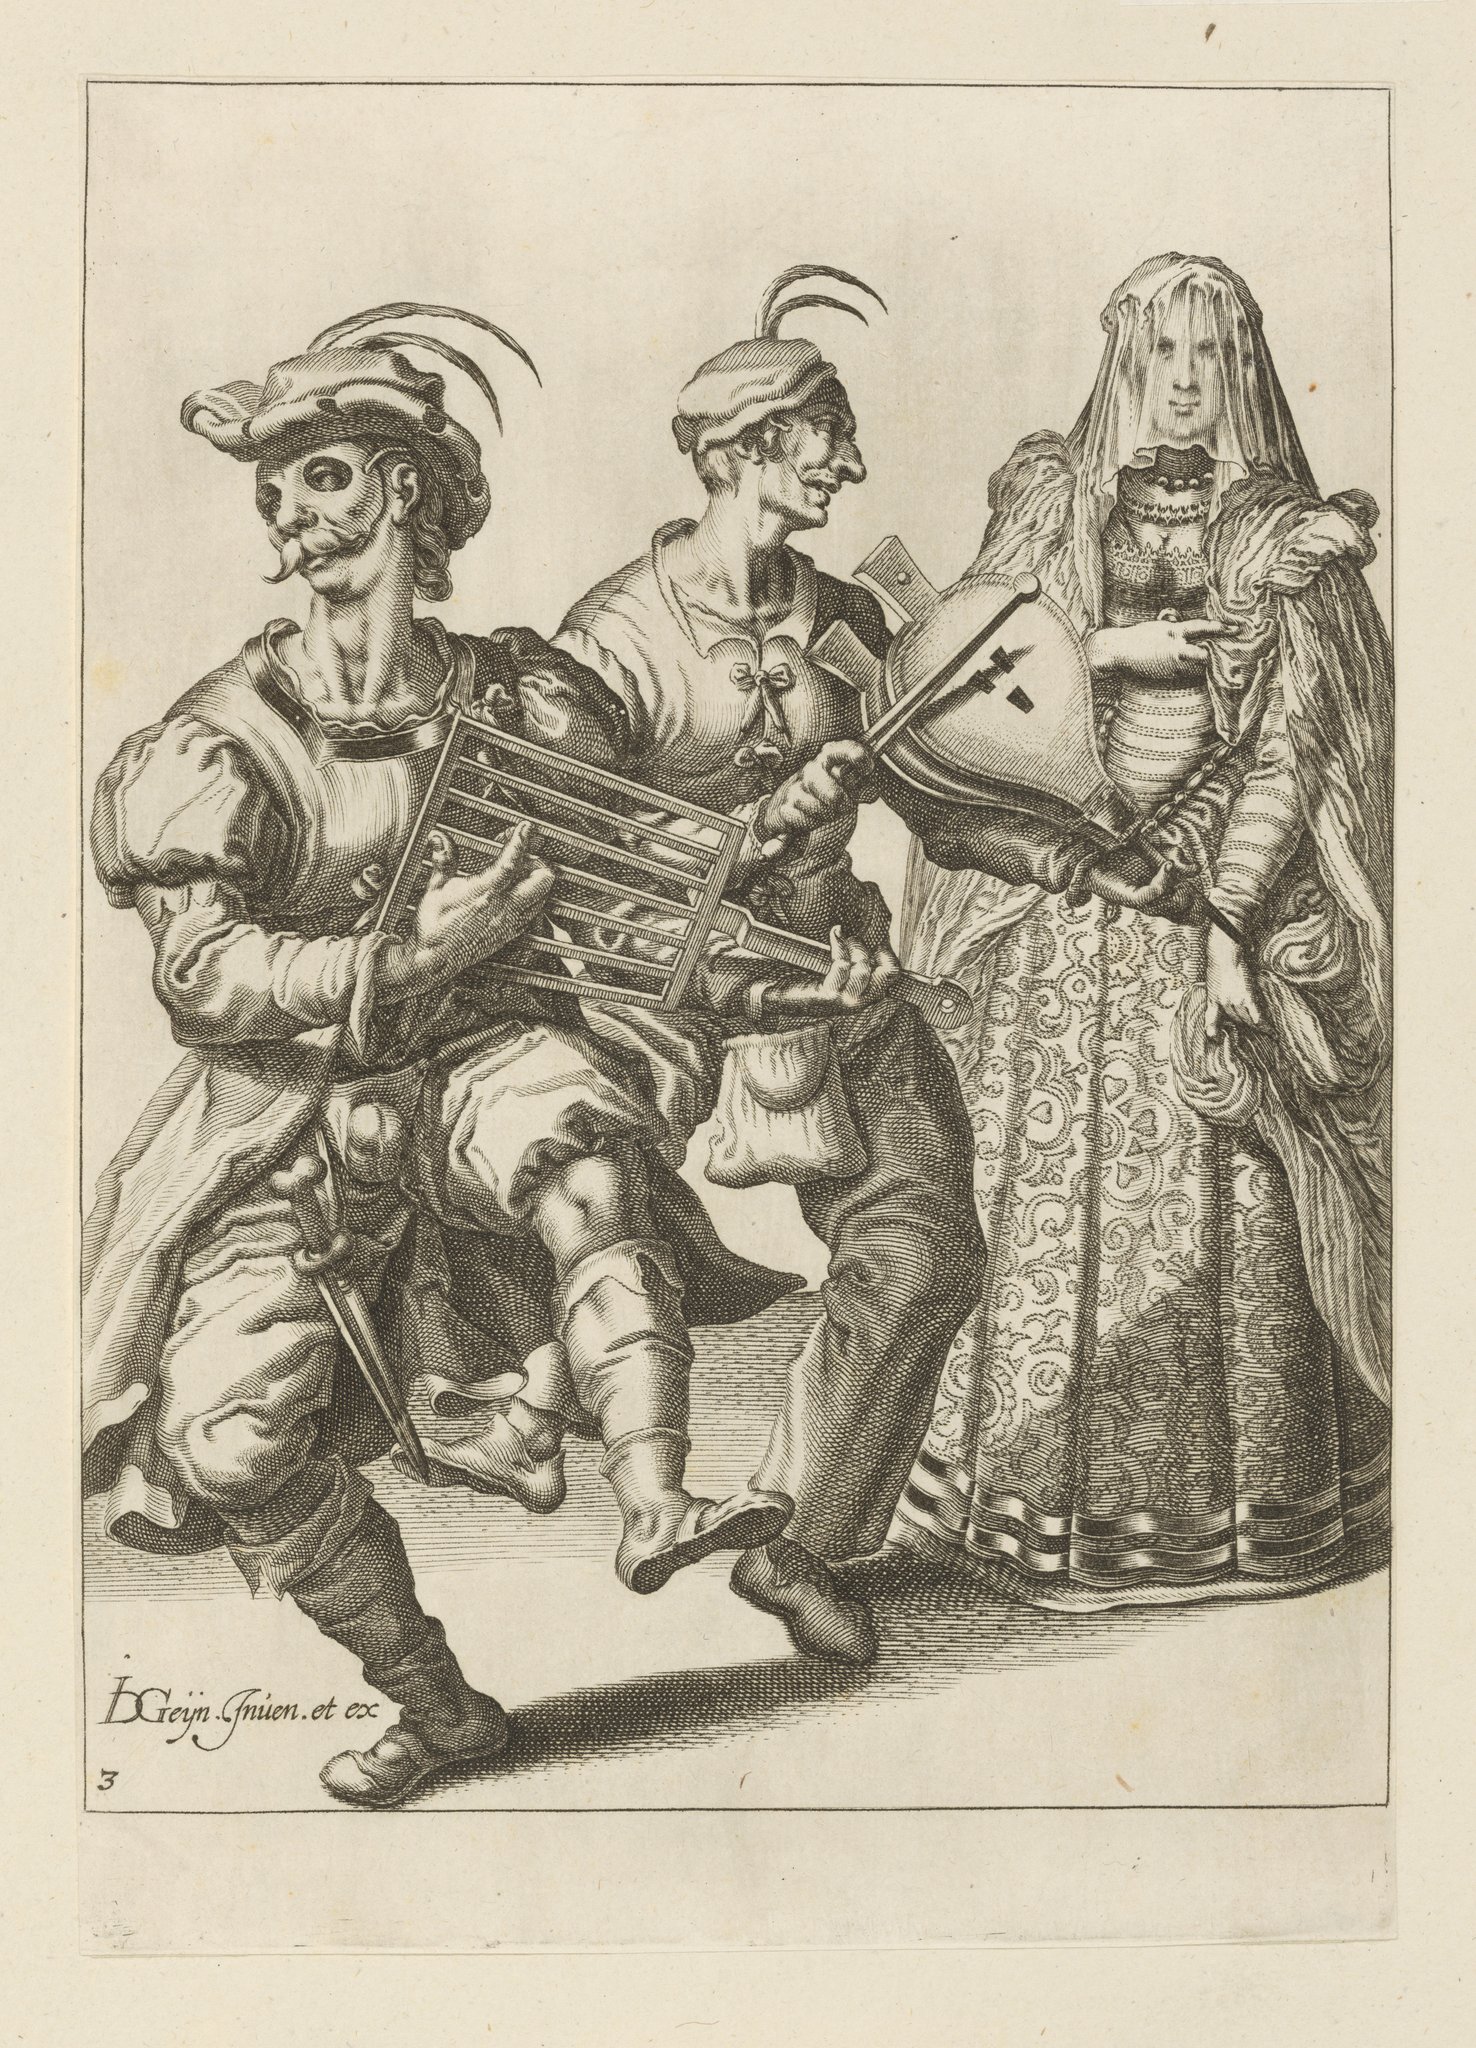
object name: print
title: A Veiled Woman with Two Musicians, plate 3 from "The Masquerades"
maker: jacques de gheyn (ii)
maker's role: artist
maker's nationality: netherlandish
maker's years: 1565-1629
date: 1595-1596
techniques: engraving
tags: musical instruments,musicians